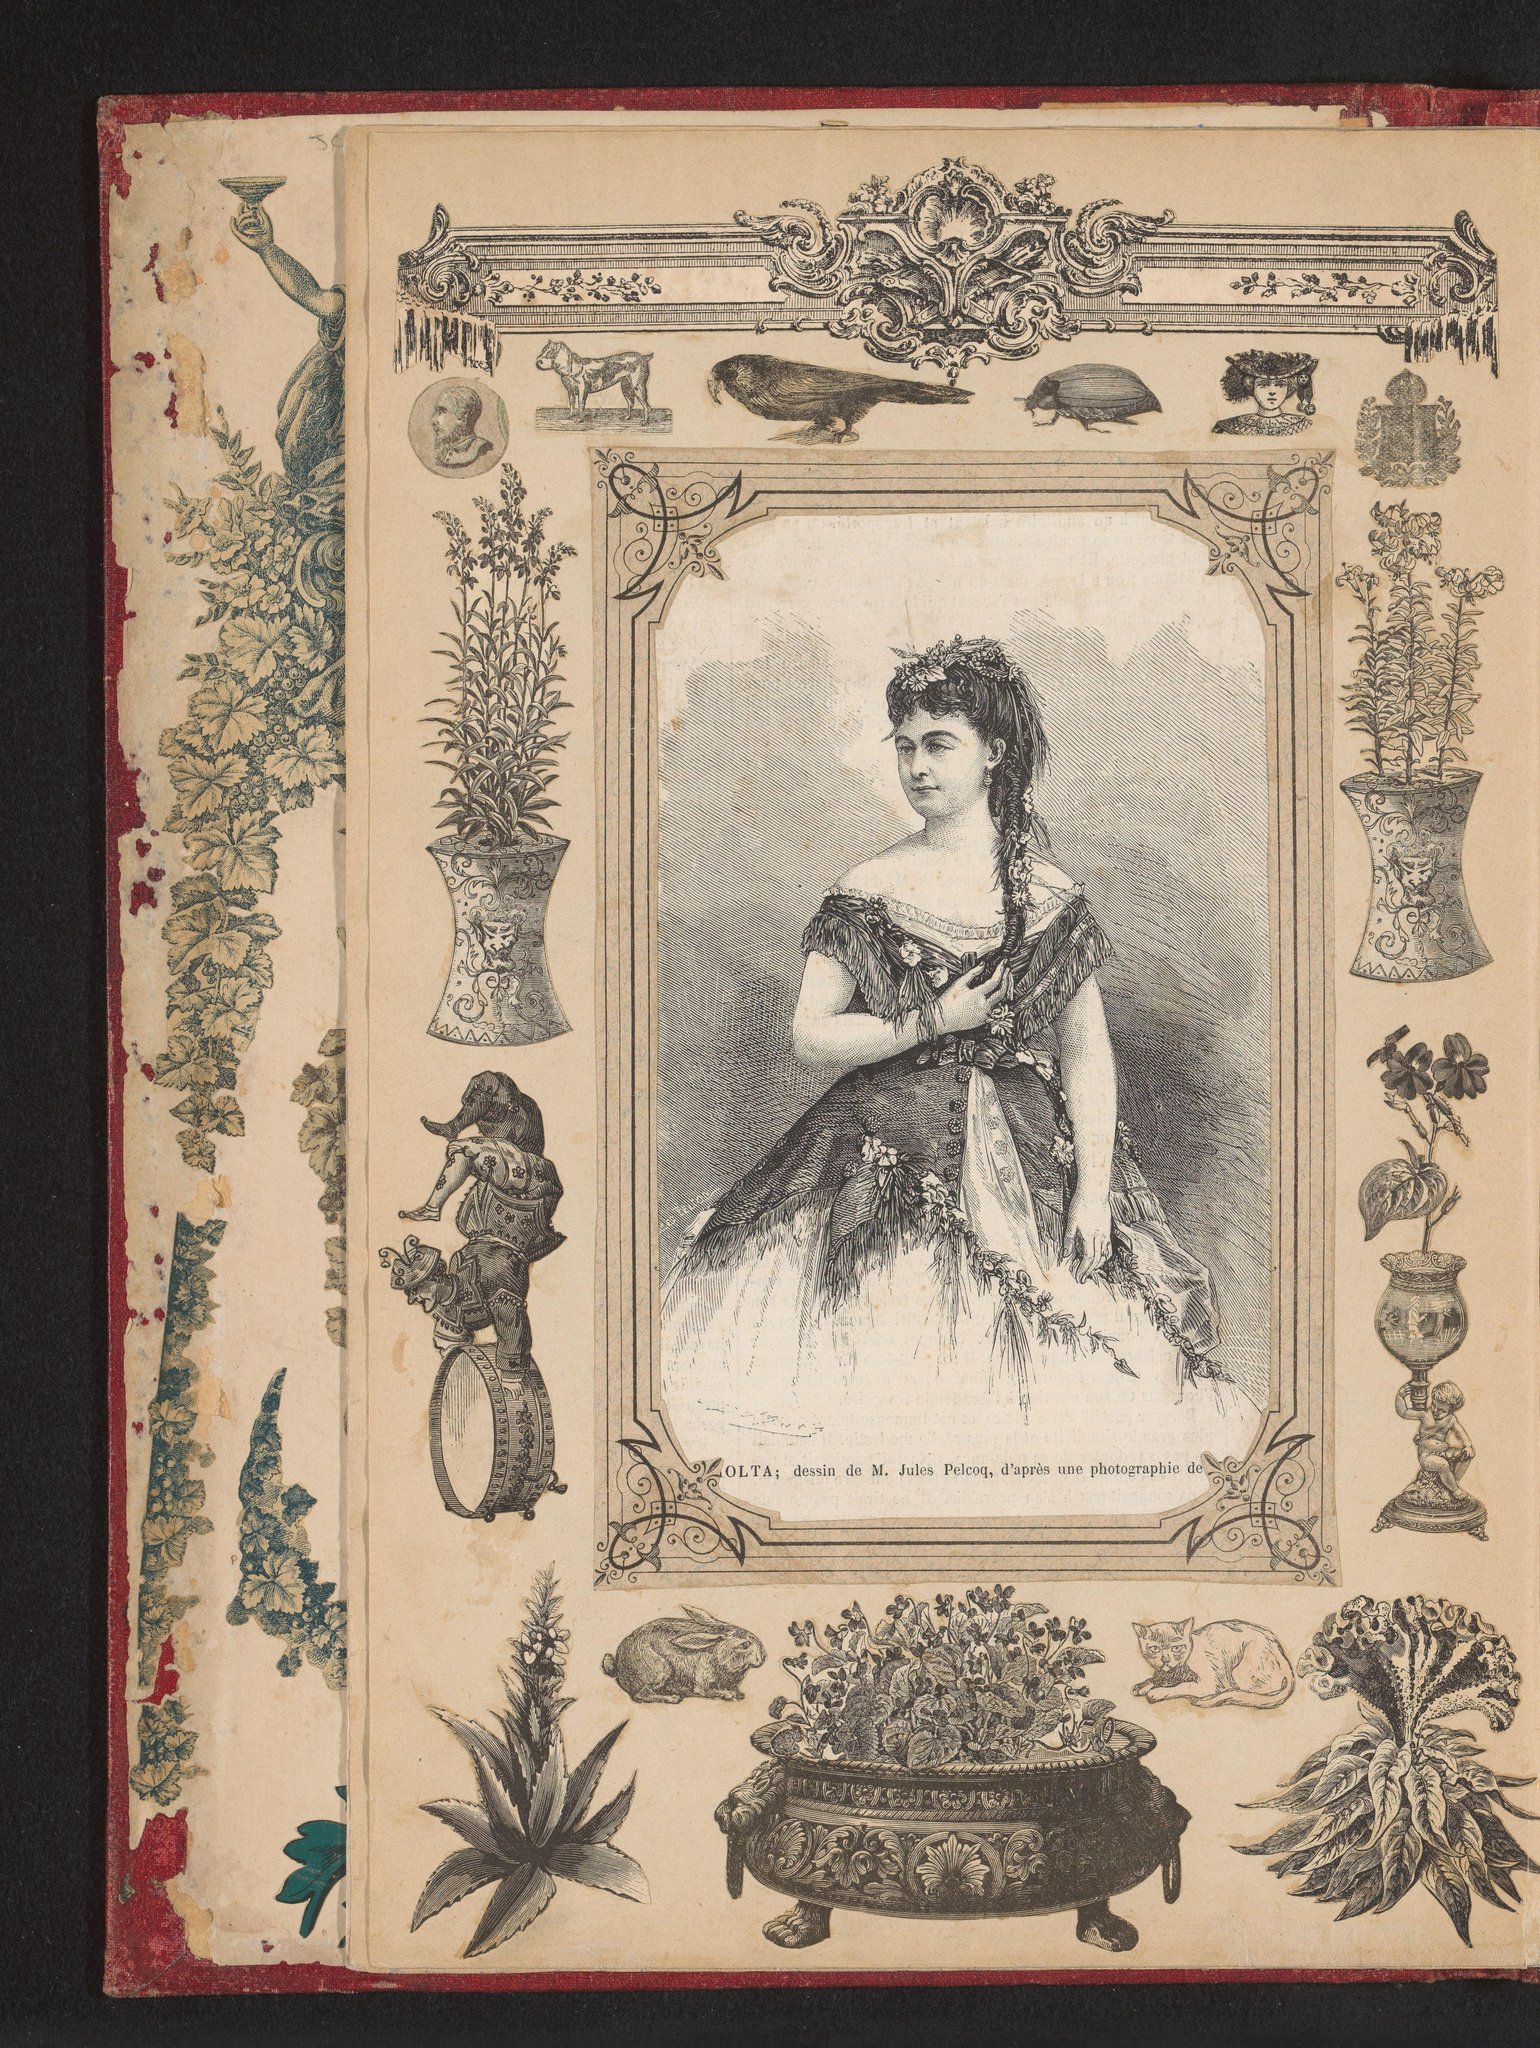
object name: collage visual work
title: Collage van uitgeknipte prenten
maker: Anonymous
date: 1870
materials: paper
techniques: engraving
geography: paris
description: Collage van uitgeknipte prenten. Onderdeel van een album met 18 bladen, aan beide zijden beplakt met uitgeknipte prenten, vermoedelijk afkomstig uit 19e-eeuwse tijdschiften.